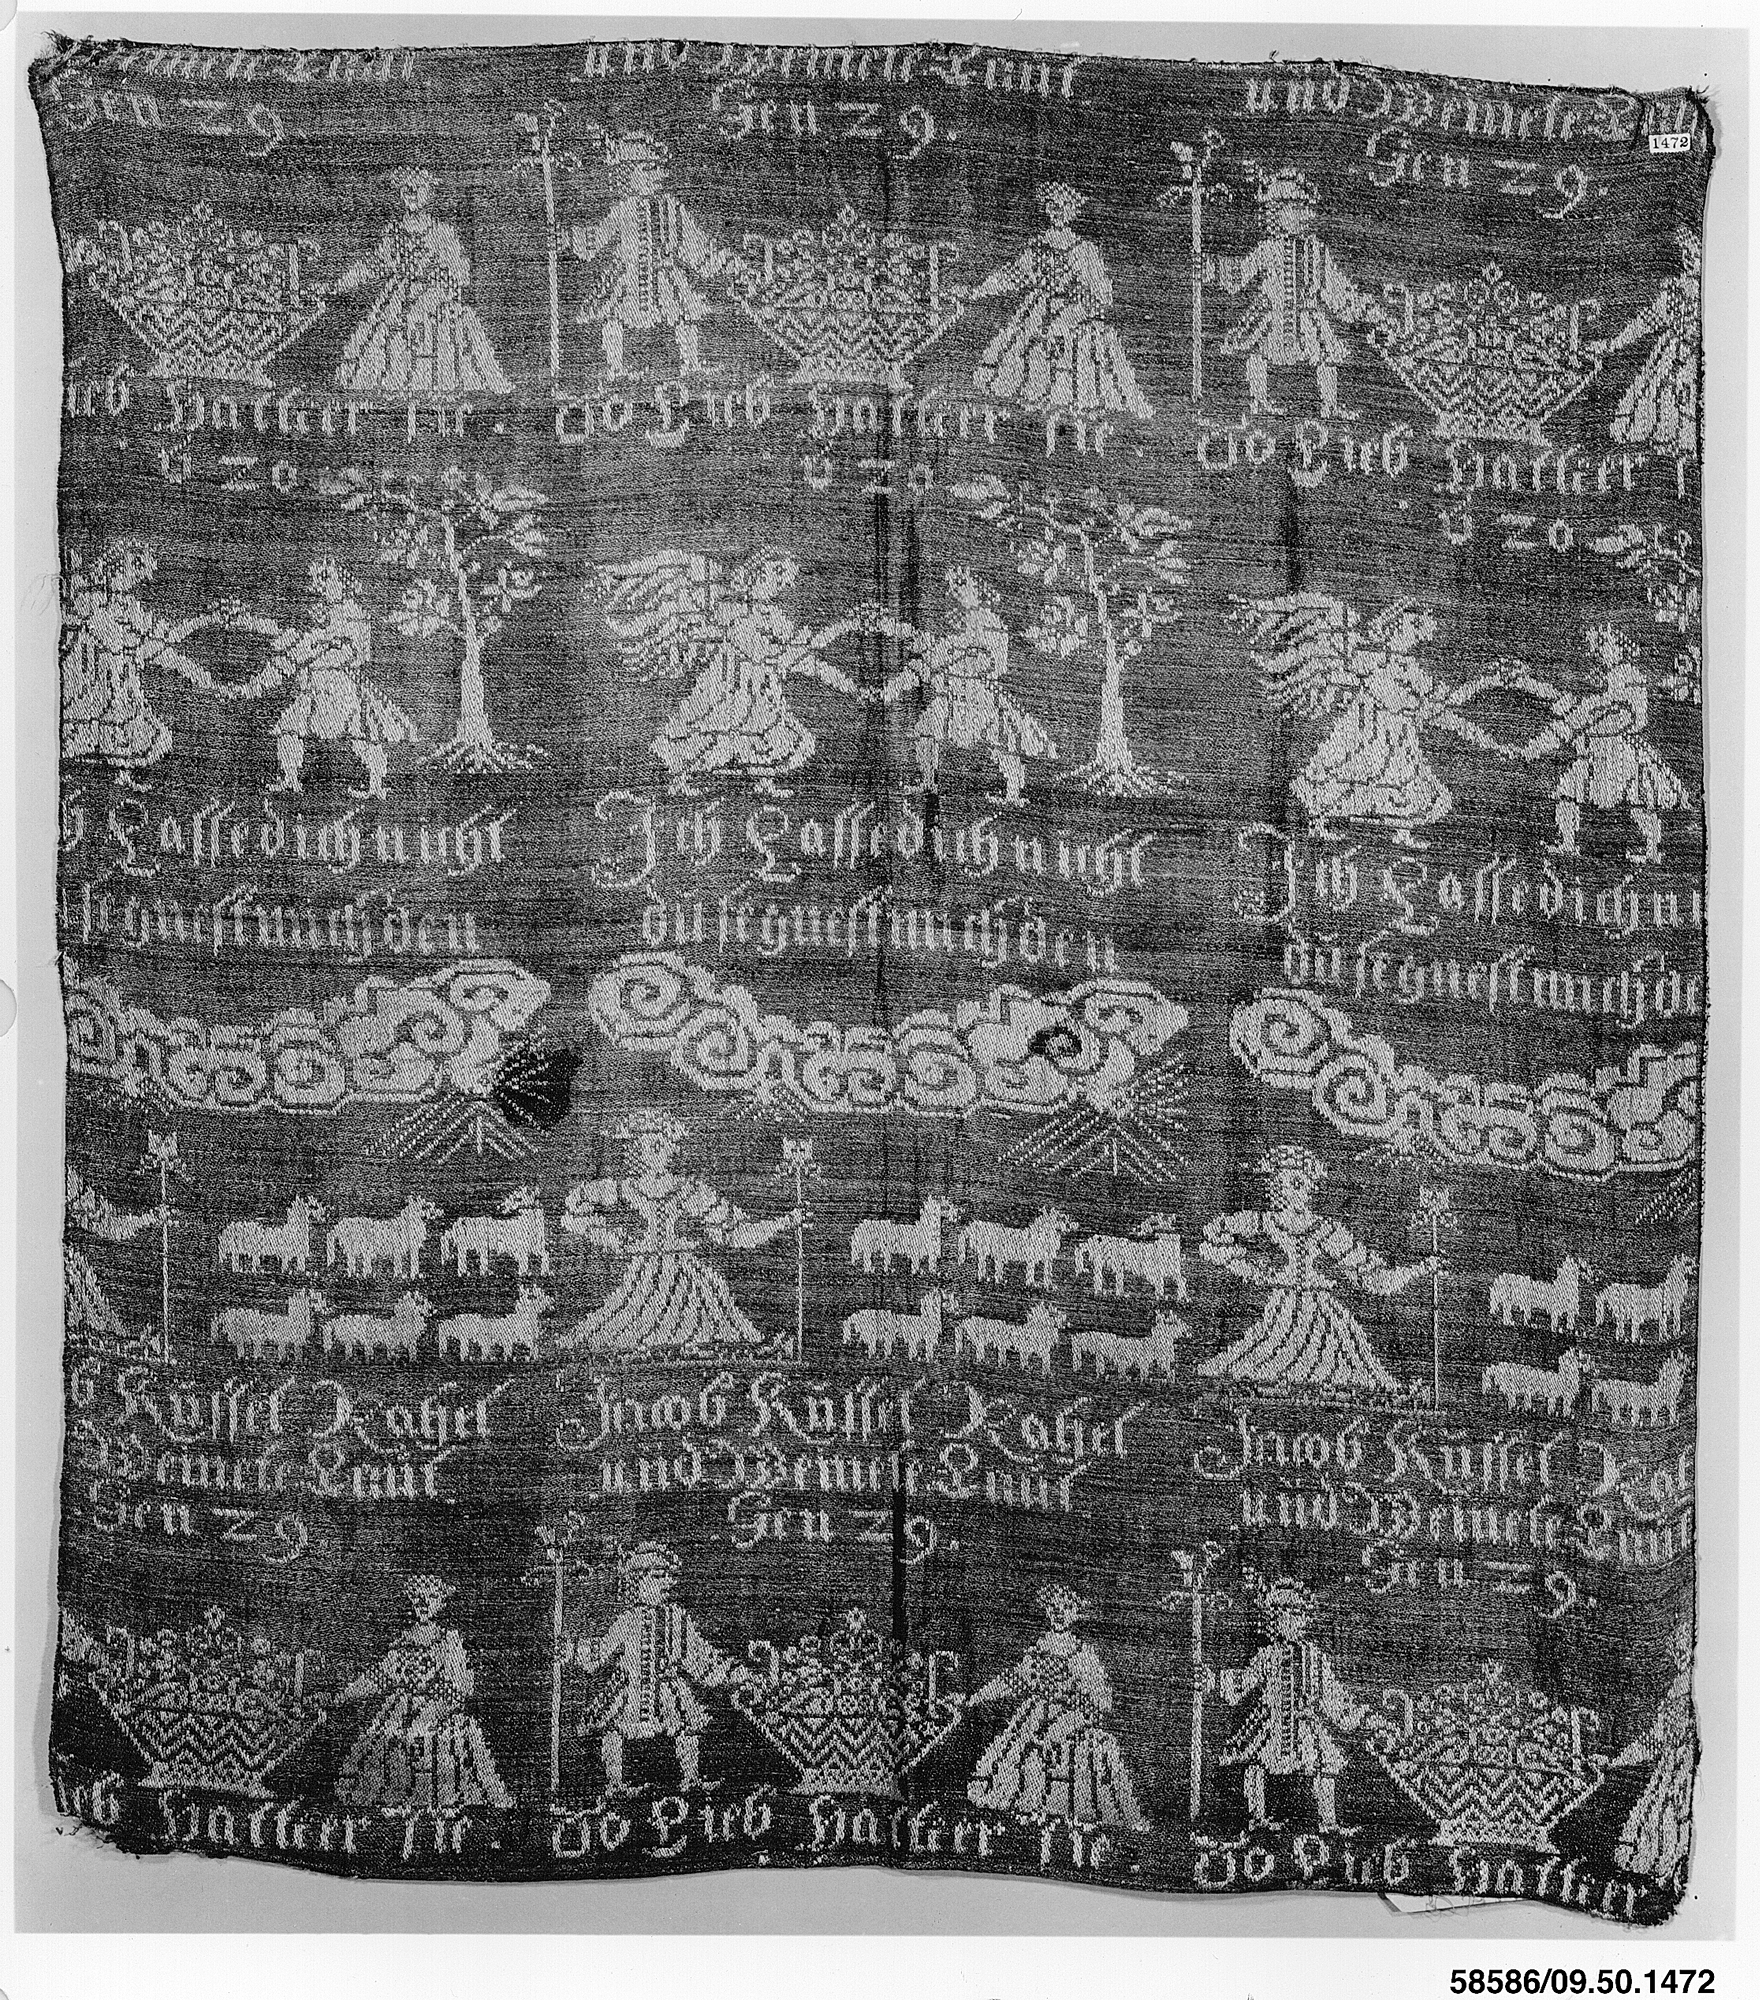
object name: piece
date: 1701-1800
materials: linen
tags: human figures,animals